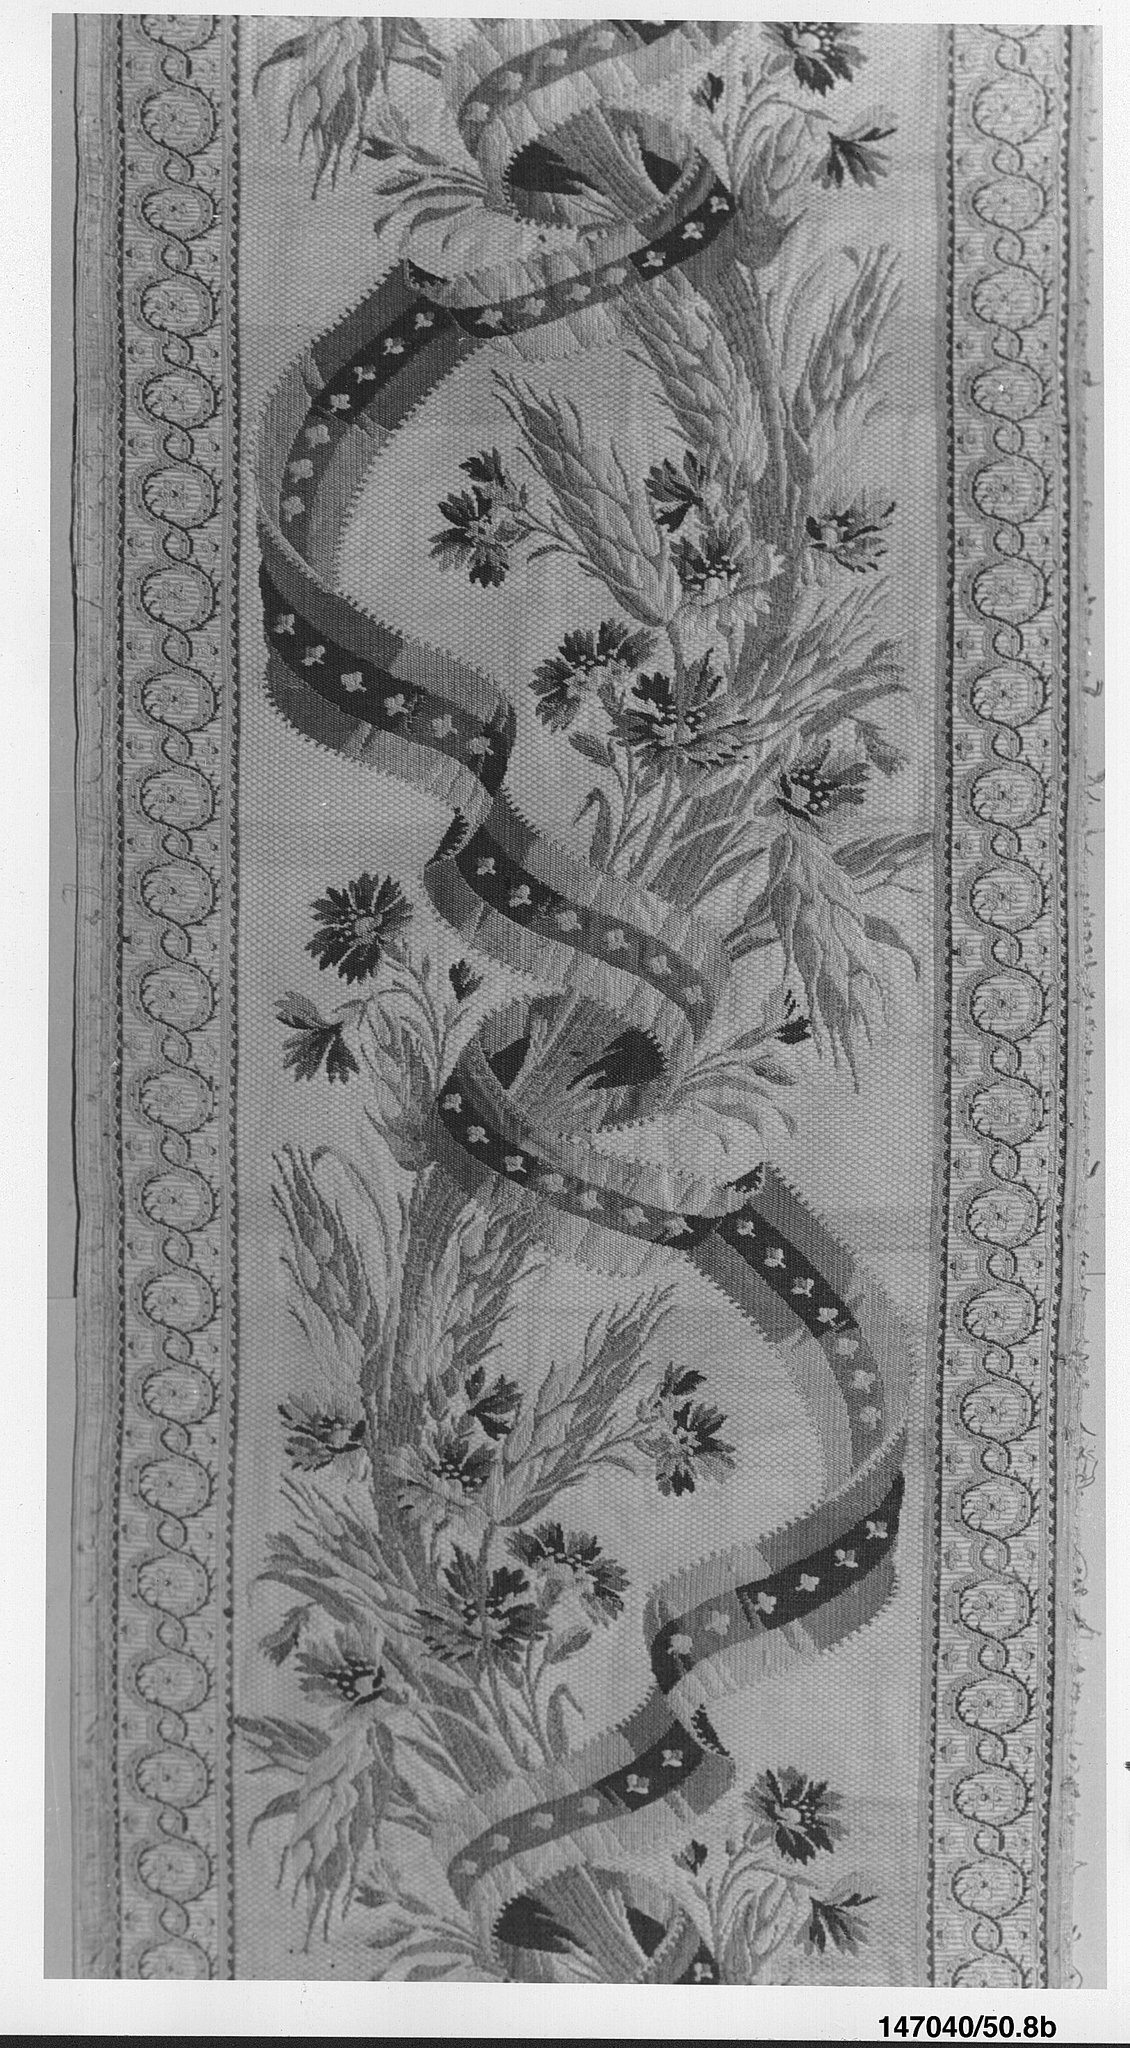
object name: piece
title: Border of woven silk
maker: philippe de lasalle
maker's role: designer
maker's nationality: french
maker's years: 1723-1804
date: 1770-1780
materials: silk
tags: flowers,plants